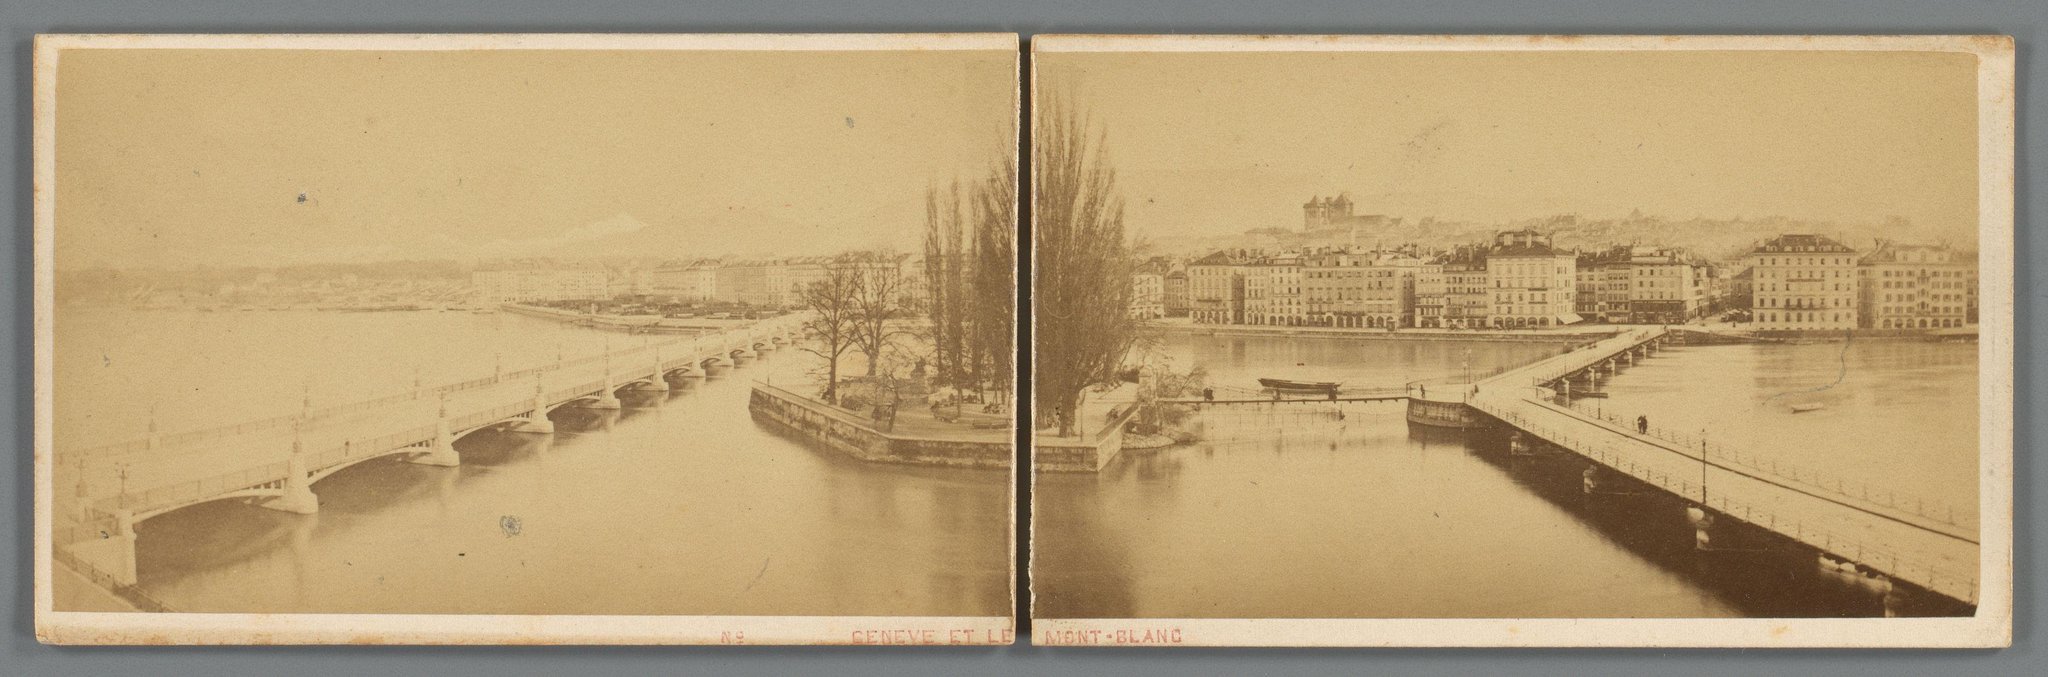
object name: photograph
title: Geneve et le Mont-Blanc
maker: auguste garcin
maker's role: fotograaf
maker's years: 1816-1895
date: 1853-1874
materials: cardboard, paper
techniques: albumen print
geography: geneva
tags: island, city-view in general; 'veduta'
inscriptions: inscription: ‘Suisse Savoie/ Garcin/ Photographe/ à/ Genève/ Midi de la France’